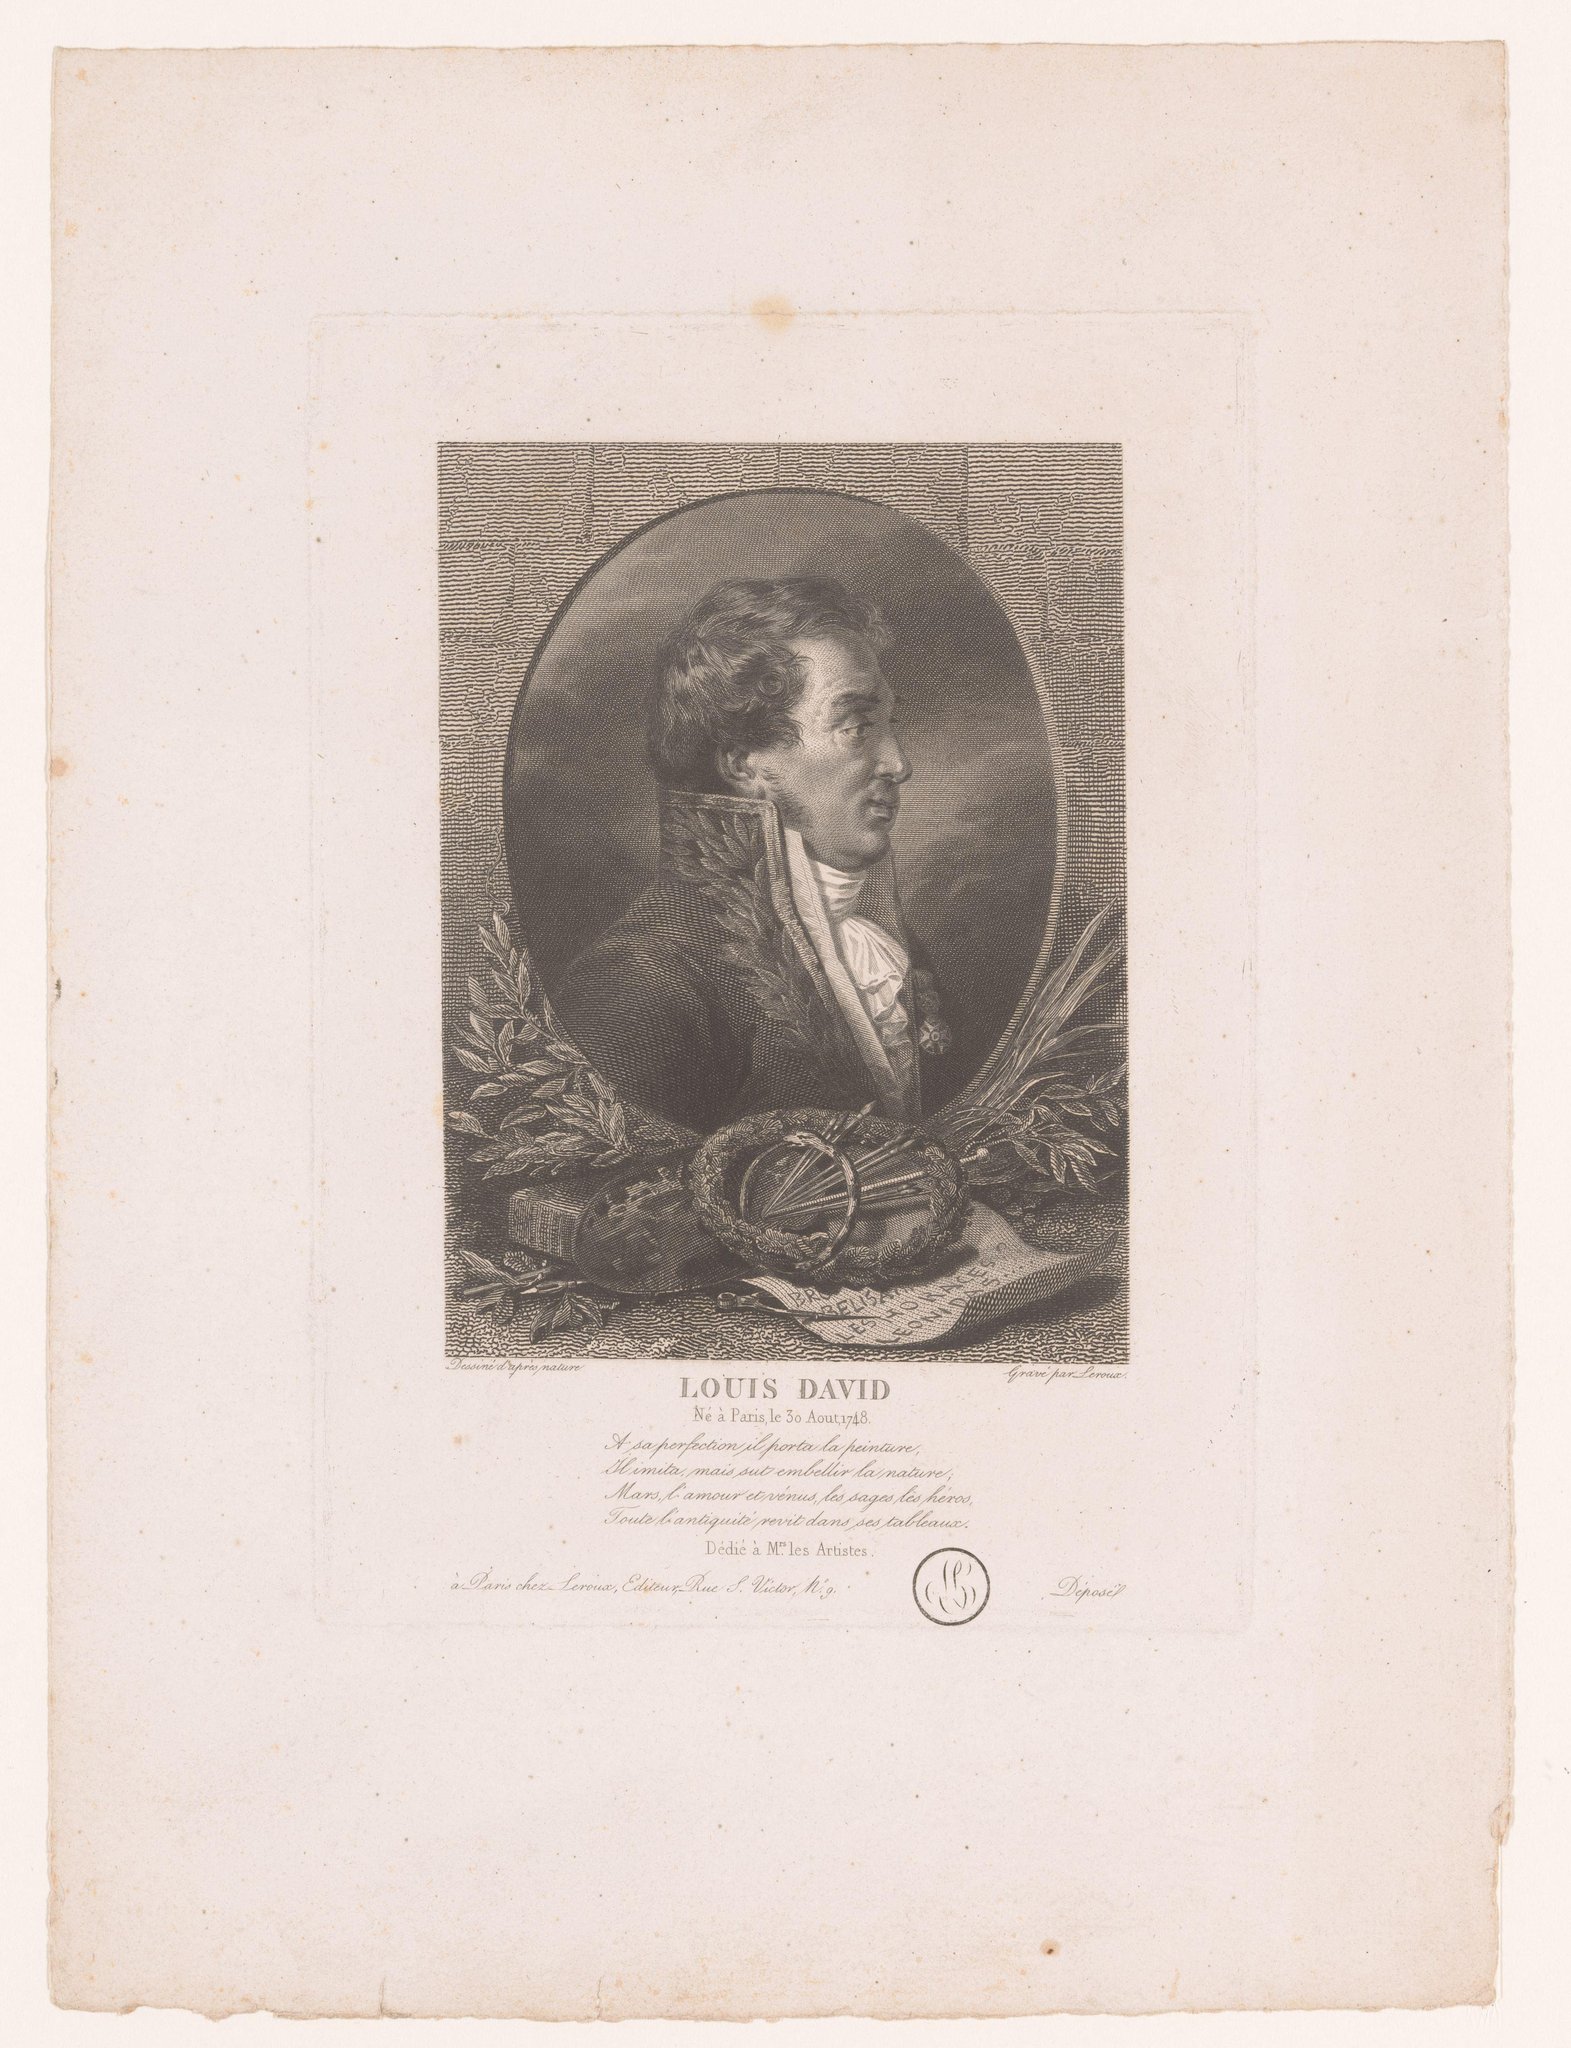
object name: print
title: Portret van Jacques-Louis David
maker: jean marie leroux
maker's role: print maker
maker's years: 1788-1870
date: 1798-1870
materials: paper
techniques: engraving, etching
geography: paris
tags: paris, brussels, draughtsman, jacques-louis david, historical persons, portrait, self-portrait of painter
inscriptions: collector's mark: Lugt 2228, collector's mark, : ‘Déposé’